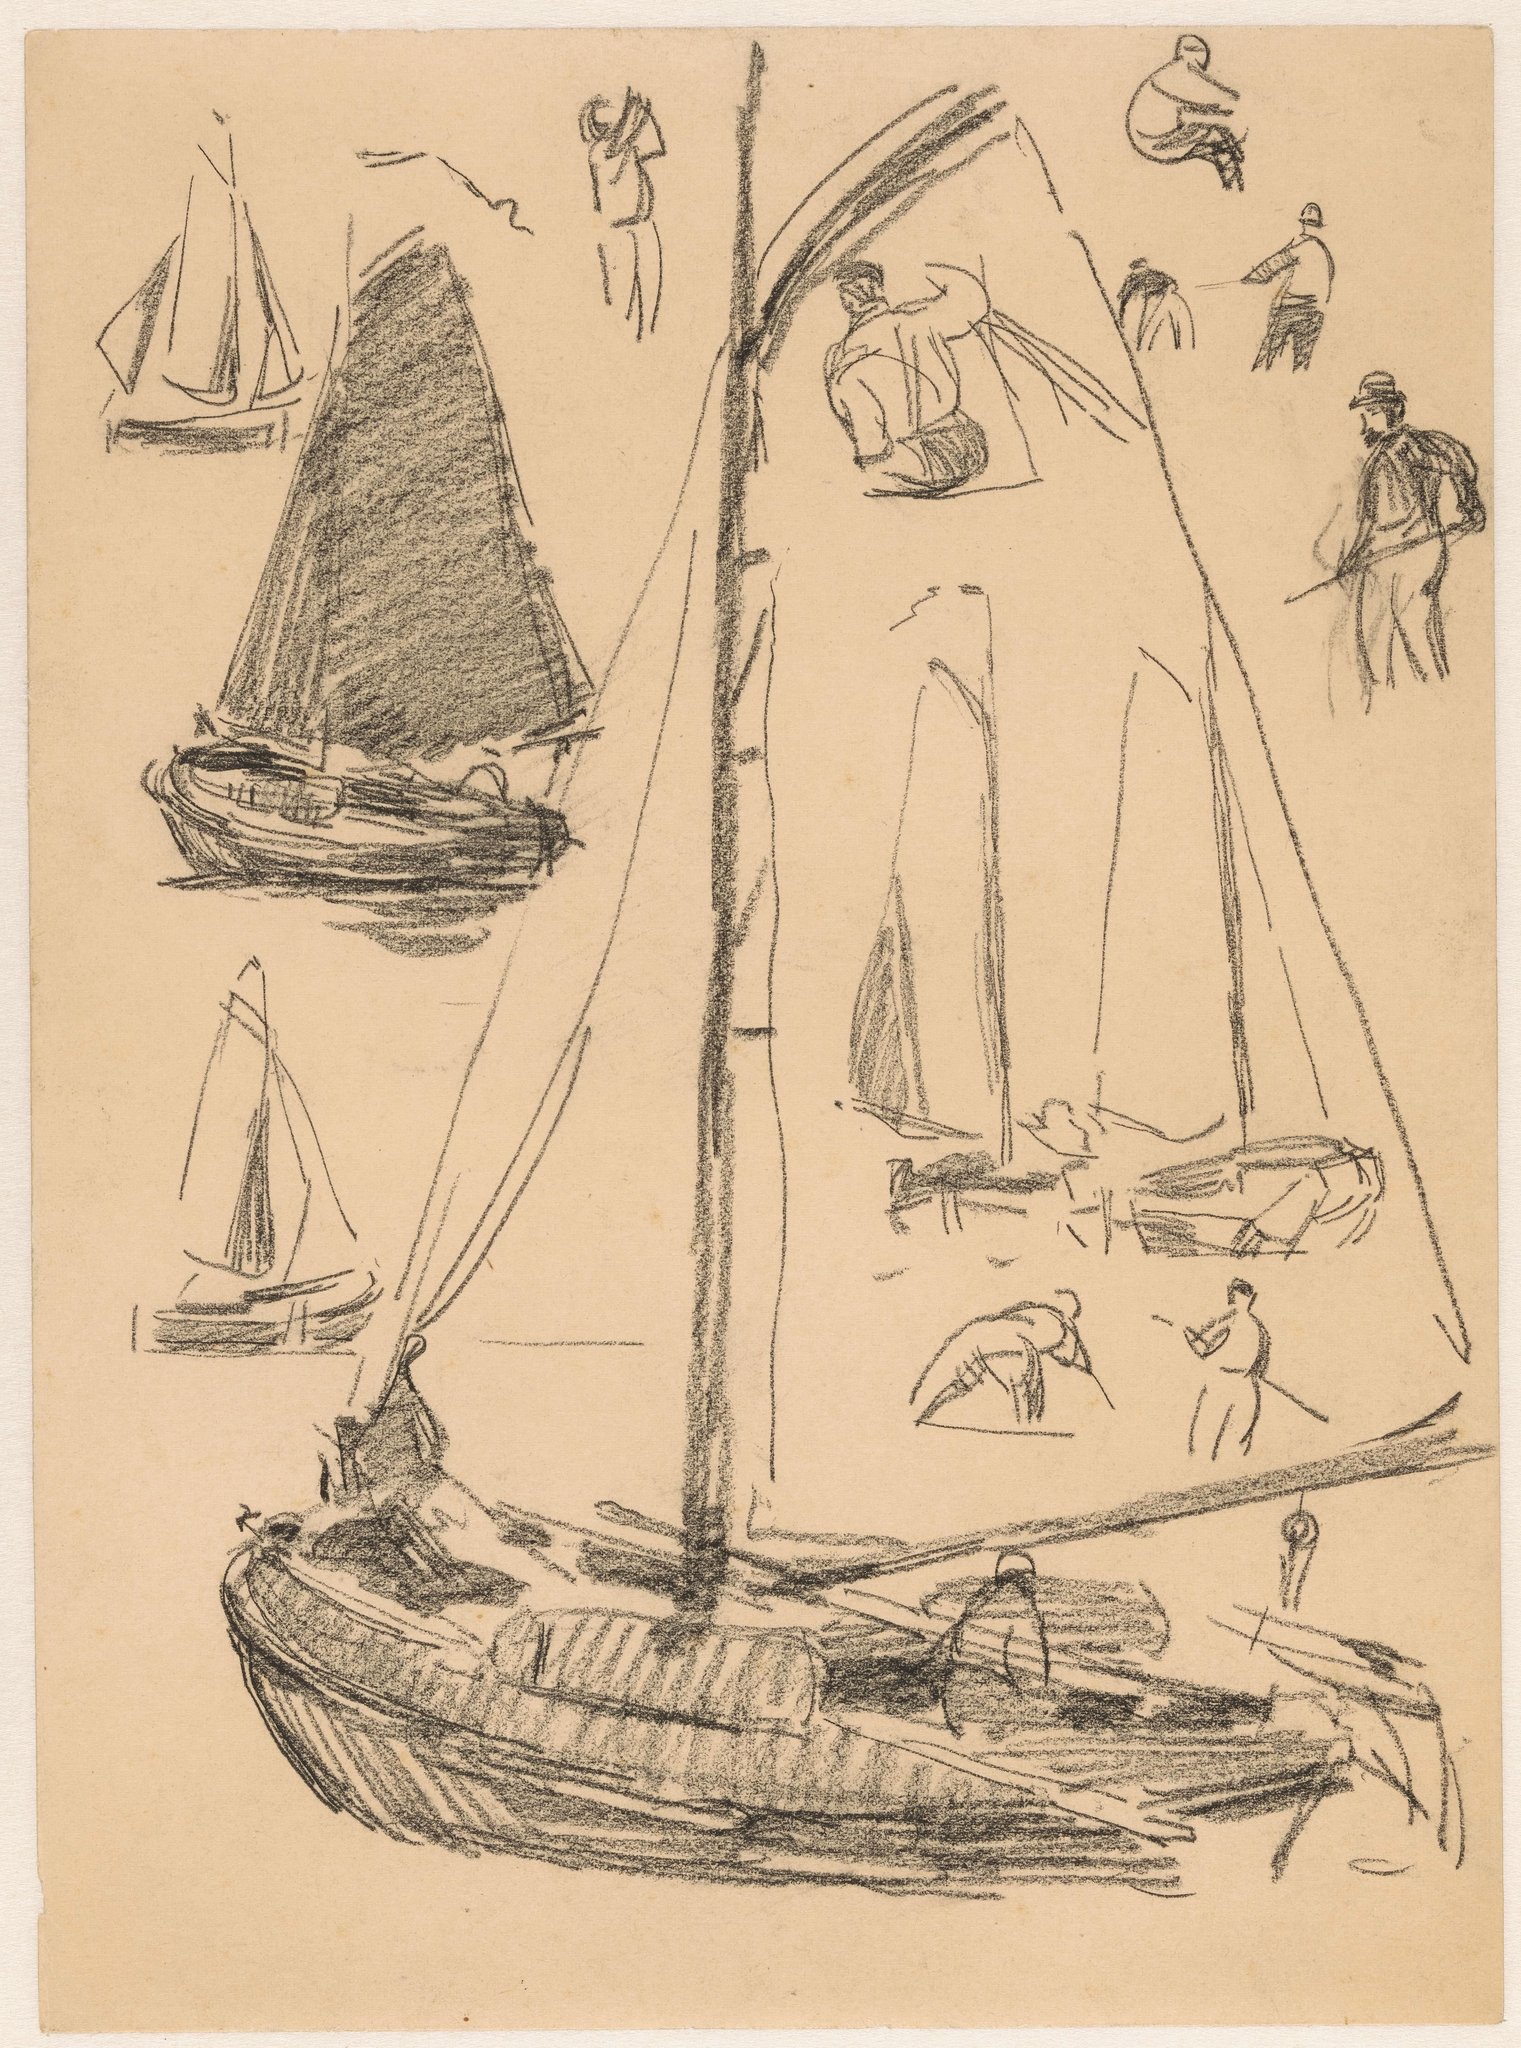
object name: drawing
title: Studieblad met diverse zeilschepen en figuren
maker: willem bastiaan tholen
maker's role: draughtsman, painter, print maker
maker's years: 1860-1931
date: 1870-1931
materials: chalk, paper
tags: ships (in general) - cc - more than one ship